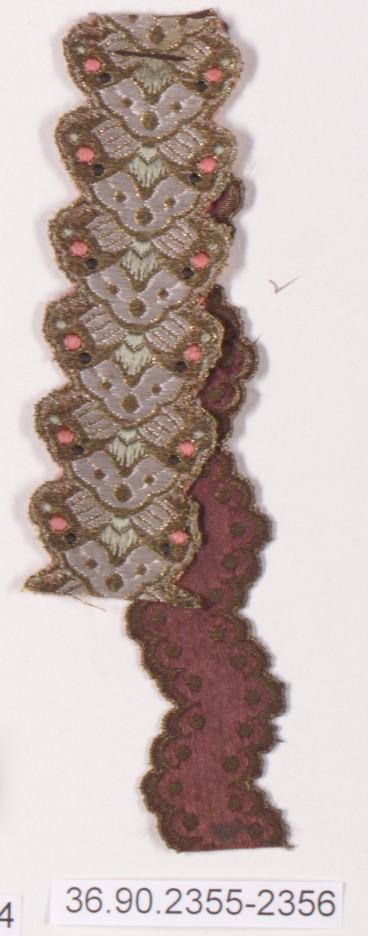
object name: ribbon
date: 1801-1900